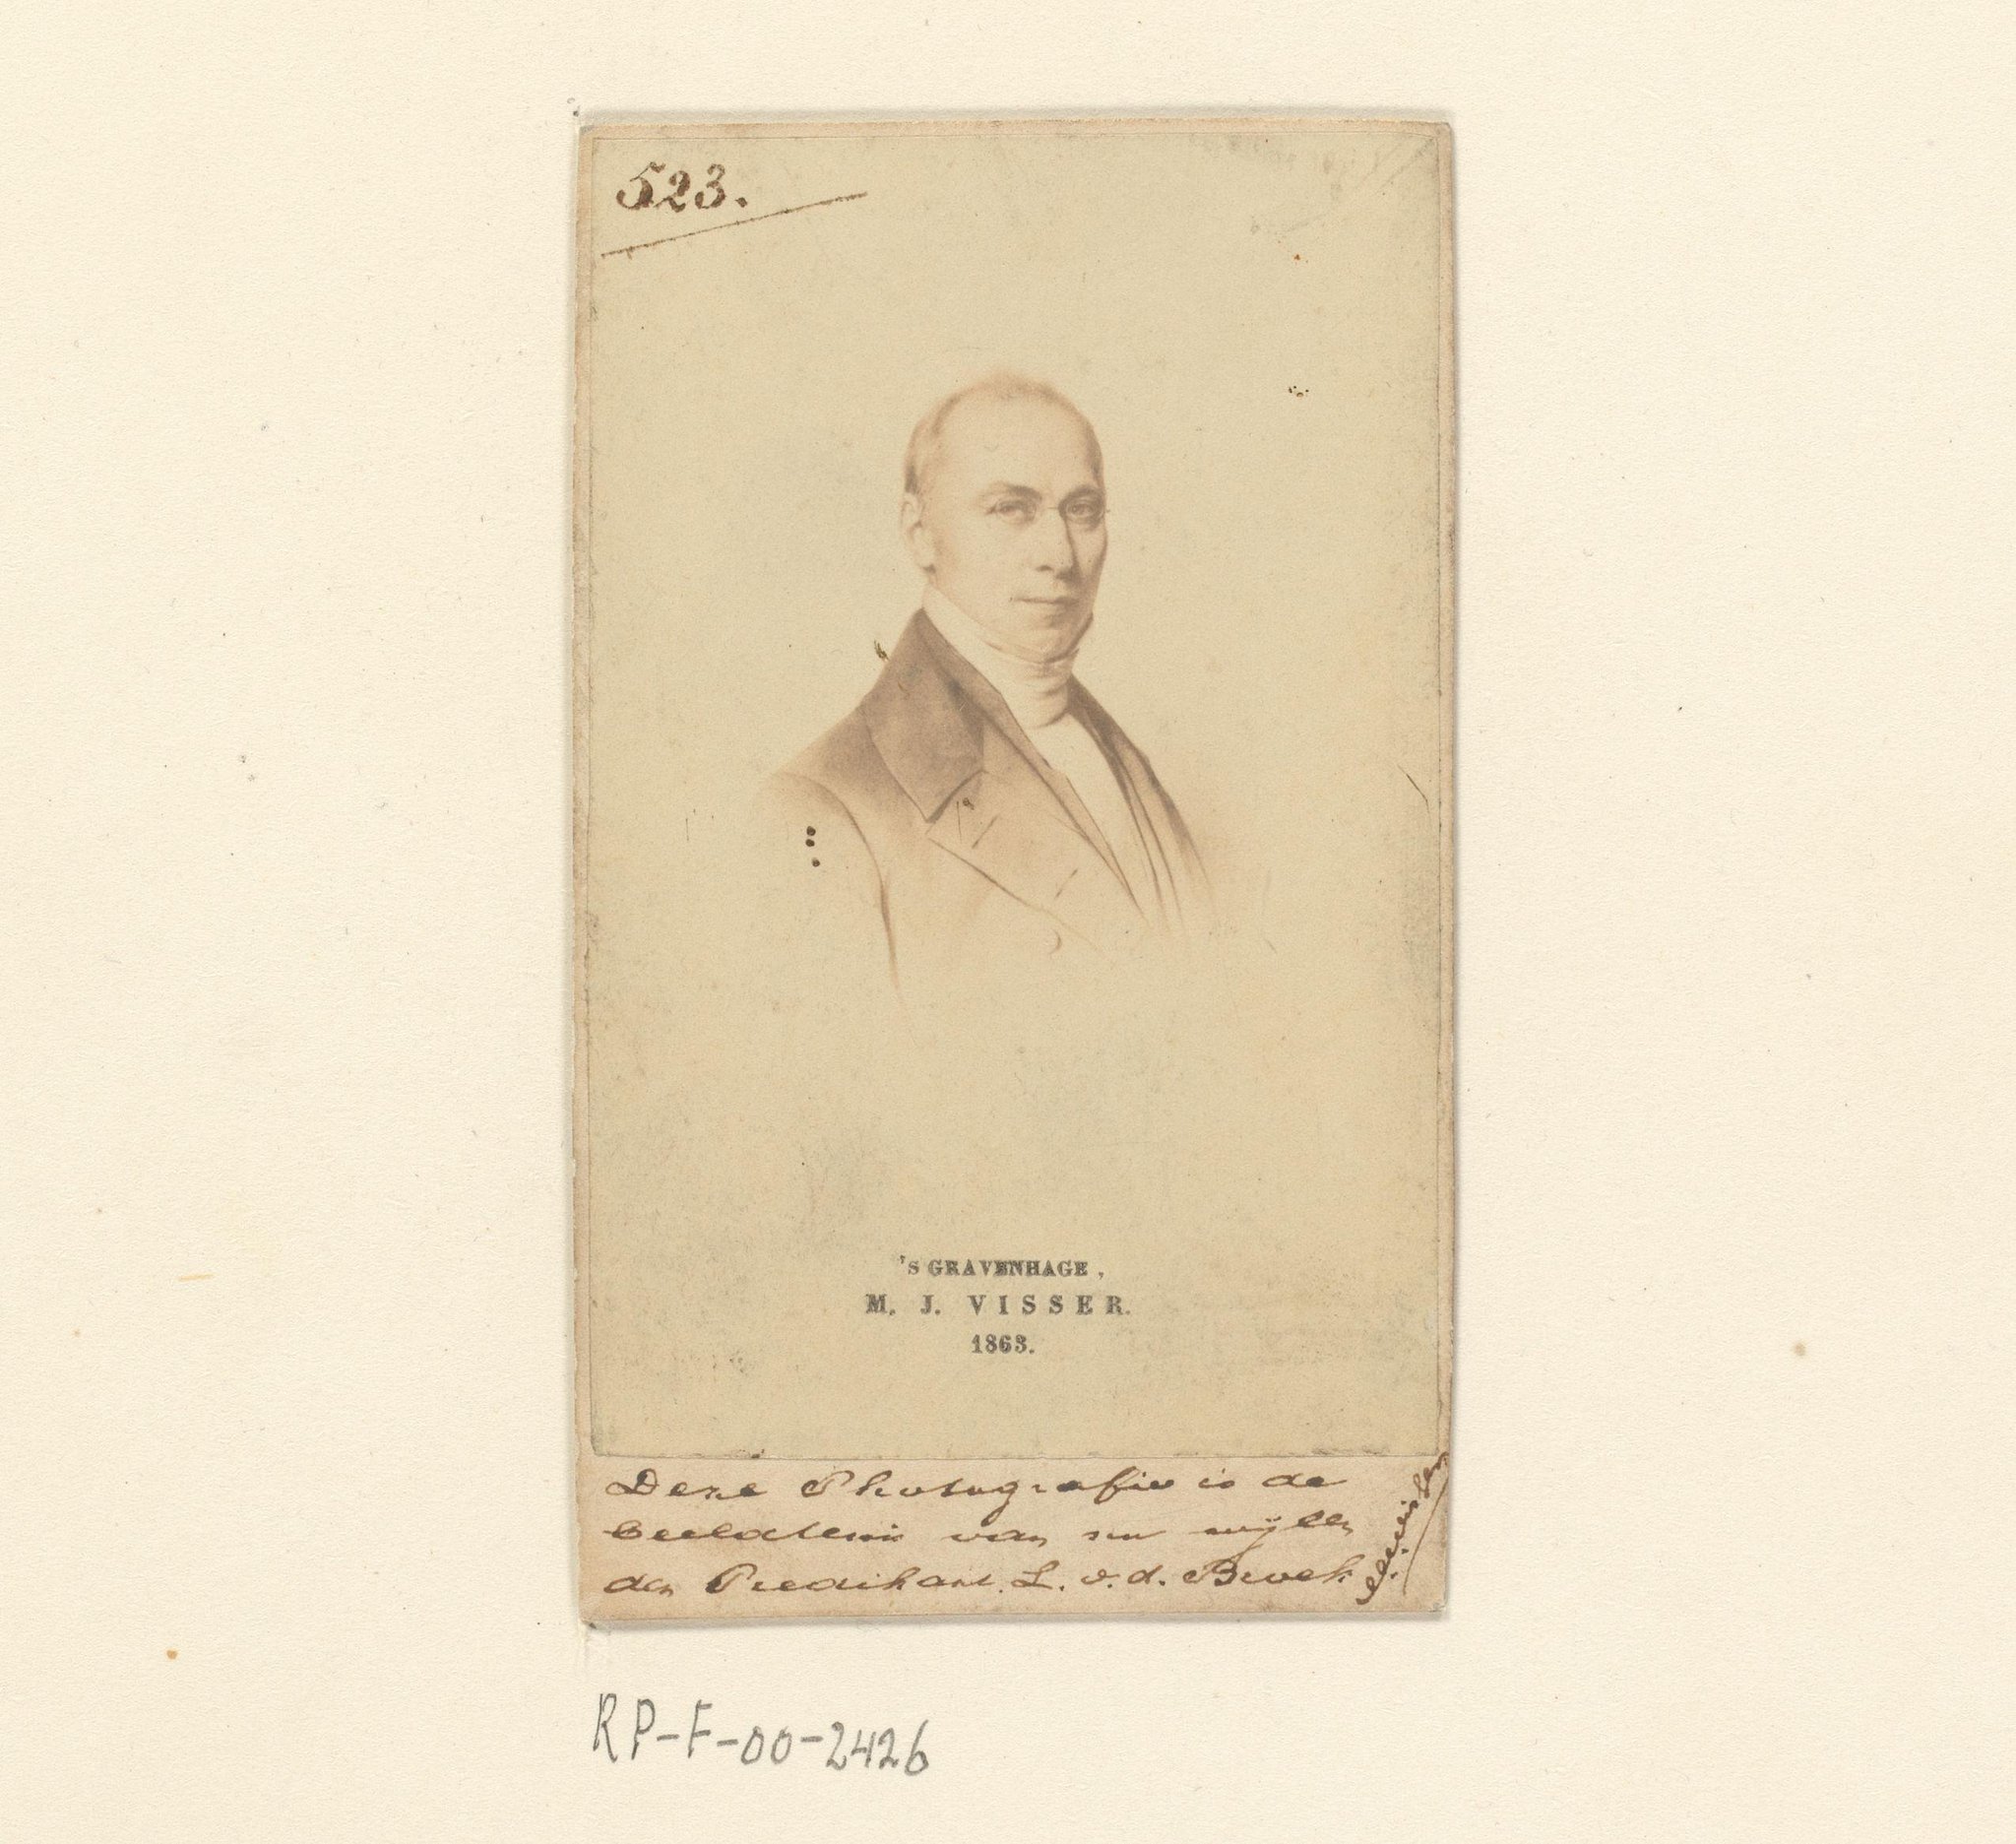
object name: photograph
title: Portret van L. van den Broek, predikant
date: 1863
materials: cardboard, paper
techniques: albumen print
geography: the hague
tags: l. van den broek, historical persons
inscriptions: : ‘De ondergeteekende/ verklaart deze/ Photografie te/ hebben uitgegeven/ 's Gravenhage,/ 4 Juny 1863./ MVisser’, : ‘de ondergetekende/ verklaart deze/ Photographie te hebben/ vervaardigd/ 's Hage/ 4 Juny/ 1863/ M. Verveer’, inscription: ‘523./ Deze Photografie is de/ beeltenis van wijlen/ den Predikant L. v.d. Broek/ MVisser’, inscription: ‘M. Verveer,/ Photographe (...) La Haye’, inscription: ‘'s Gravenhage./ M.J. Visser/ 1863.’